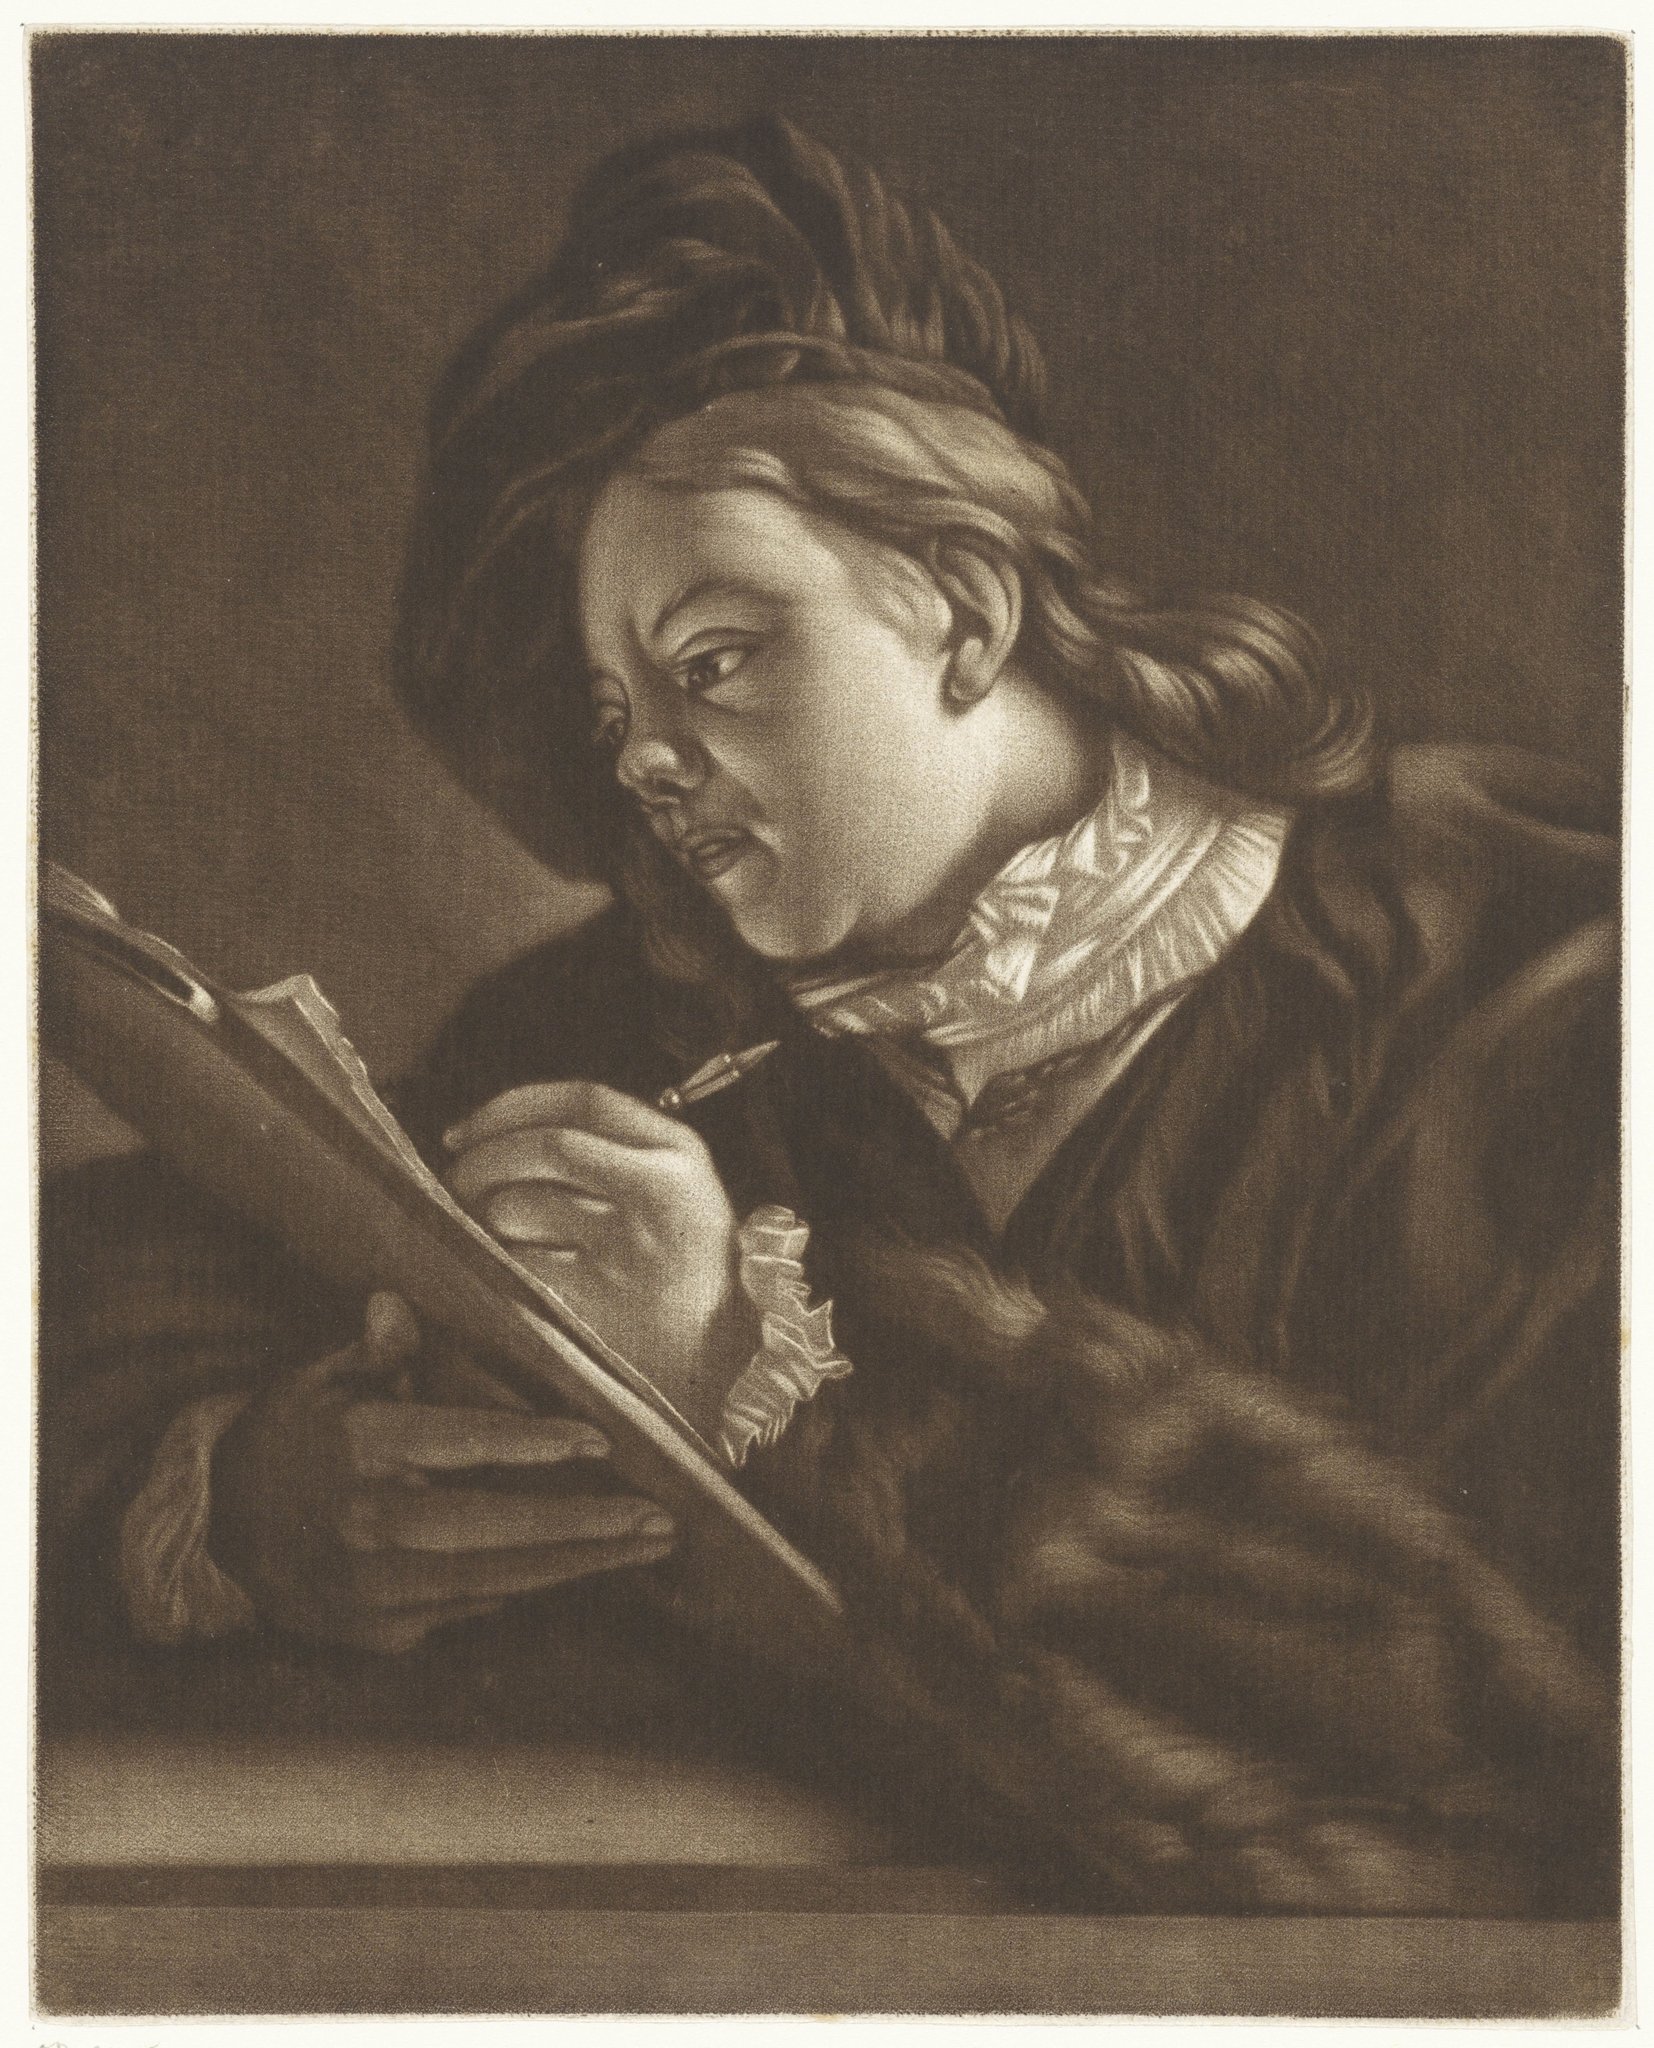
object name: print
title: Tekenaar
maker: jan stolker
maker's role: draughtsman, painter, print maker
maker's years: 1724-1785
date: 1734-1785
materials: paper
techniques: mezzotint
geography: northern netherlands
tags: head-gear: cap (+ men's clothes), draughtsman at work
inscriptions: collector's mark: Lugt 240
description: Een jongen tekent geconcentreerd op het blad dat hij op een plankje voor zich houdt. Hij draagt een muts.